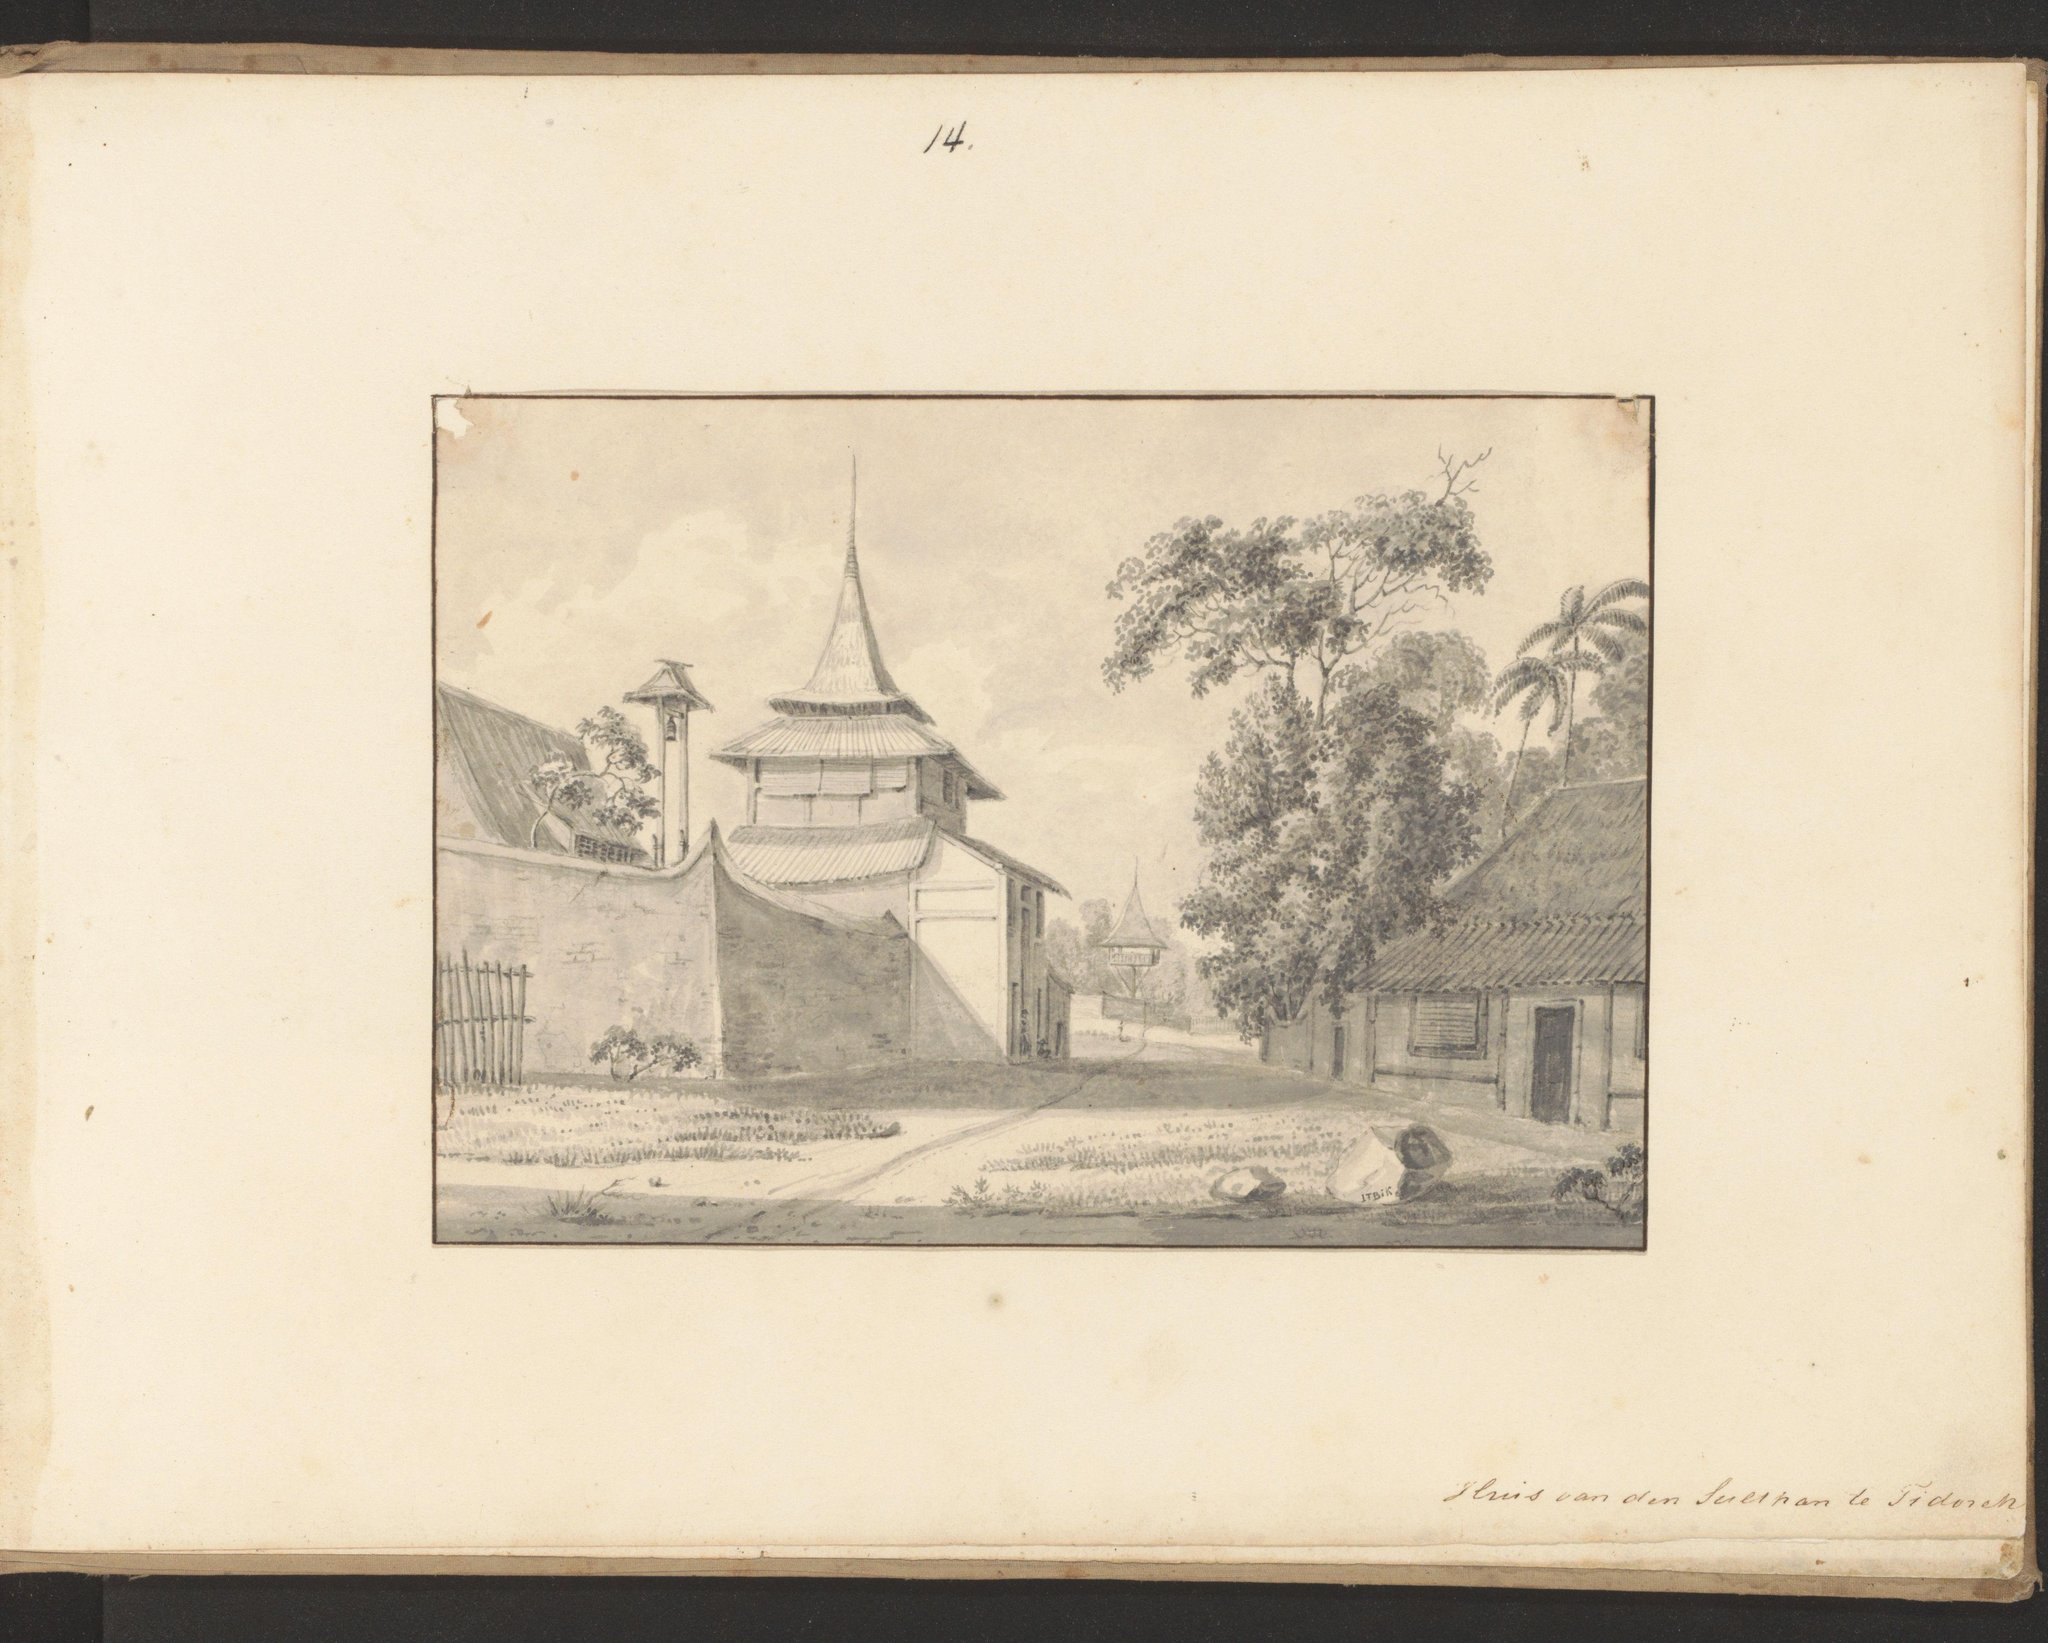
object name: album leaf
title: Huis van de Sultan op Tidore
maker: jannes theodorus bik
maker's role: draughtsman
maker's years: 1796-1872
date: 1821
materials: ink, paper, pencil, watercolor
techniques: brush, pen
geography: tidore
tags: rural housing, e.g. country-house, villa, cottage, village street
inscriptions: annotation: ‘Huis van den Sulthan te Tidoren’, signature: ‘JTBik’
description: Blad 14 uit een album met 14 tekeningen en een prent.